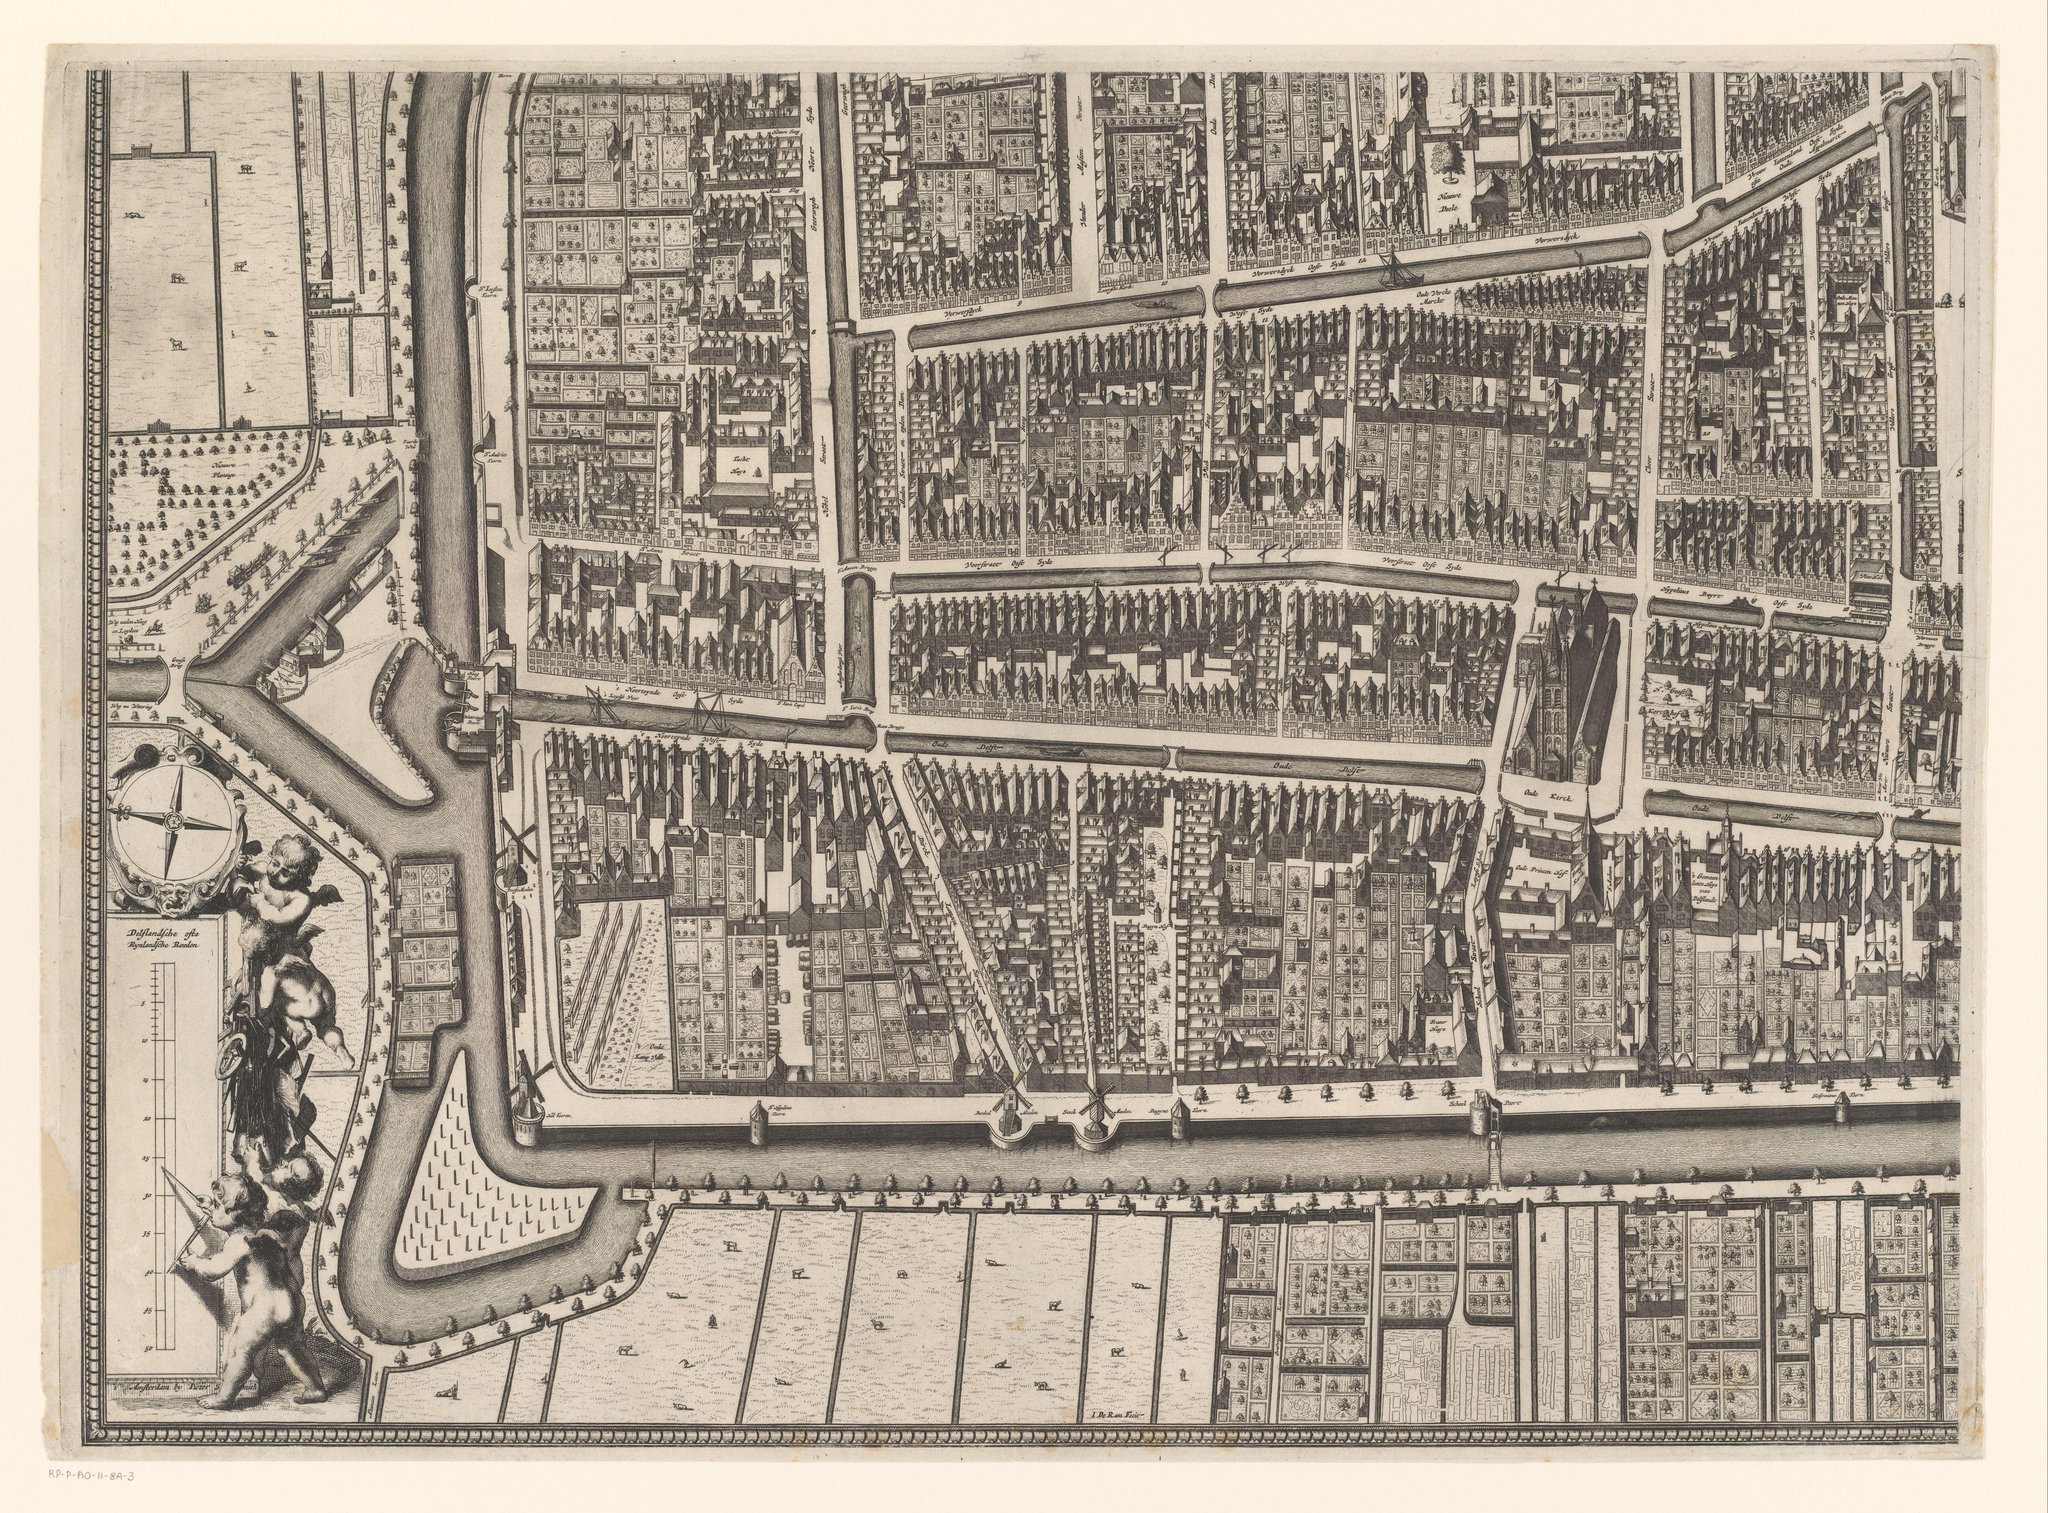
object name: area plan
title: Plattegrond van de Kaart Figuratief van Delft (deel linksonder)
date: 1678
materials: paper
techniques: engraving, etching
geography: delft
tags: coat of arms (as symbol of the state, etc.) (+ city; municipal), maps of cities, instruments used in geodesy, surveying instruments, delft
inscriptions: collector's mark: Lugt 2228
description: Deze prent is onderdeel van de tweede staat van de plattegrond van de zogenaamde Kaart Figuratief (Caerte figuratyff / Kaerte figuratyf) van Delft, een wandkaart van Delft die voor het eerst werd uitgegeven in 1678. Deze kaart bestaat uit een plattegrond van Delft (RP-P-AO-11-8A) met daaromheen een rand. De rand bestaat uit een profiel van Delft (RP-P-AO-11-11), een profiel van Delfshaven met daaronder de wapenschilden van de burgemeesters van de stad (RP-P-AO-13-51-1 en RP-P-AO-13-51-2), 24 kleinere prenten (kaarten, afbeeldingen van gebouwen en graven van bekende personen, o.a. RP-P-AO-11-15, RP-P-AO-11-16, RP-P-AO-11-17, RP-P-AO-11-18, RP-P-AO-11-19, RP-P-AO-11-20, RP-P-AO-11-21, RP-P-AO-11-23, RP-P-AO-11-24, RP-P-AO-11-27, RP-P-AO-11-28, RP-P-AO-11-29, RP-P-AO-11-30, RP-P-AO-11-31, RP-P-AO-11-33C, RP-P-AO-11-34, RP-P-AO-11-35, RP-P-AO-11-35-2, RP-P-AO-13-49, RP-P-AO-13-52, RP-P-AO-13-53, RP-P-AO-13-54-1 en RP-P-1909-6463) en een beschrijving van de stad (RP-P-AO-11-8E). In 1678 werd de kaart, in opdracht van het Delftse stadsbestuur, voor het eerst in zijn geheel uitgegeven door Pieter Smith. Pieter Mortier (I) verzorgde in 1703, tevens in opdracht van het stadsbestuur, een tweede uitgave. Voor deze druk bracht graveur Thomas van der Wilt enkele aanpassingen aan op de platen van de plattegrond. De randplaten lijken ongewijzigd te zijn gebleven, hoewel de plaat met de wapens van de burgemeesters werd vervangen door een nieuwe plaat met wapens van de toen zittende burgemeesters. Van de plattegrond zijn dus twee staten bekend. De tweede staat van de plattegrond is in 1752, waarschijnlijk zonder de randprenten, opnieuw uitgegeven. Het is onbekend wie deze druk heeft verzorgd. De kaart kon op verschillende manieren gemonteerd worden. Voor zowel de uitgave van 1678 als die van 1703 is een instructie bekend. Voor een exemplaar van de instructie uit 1703 zie RP-P-AO-11-93.